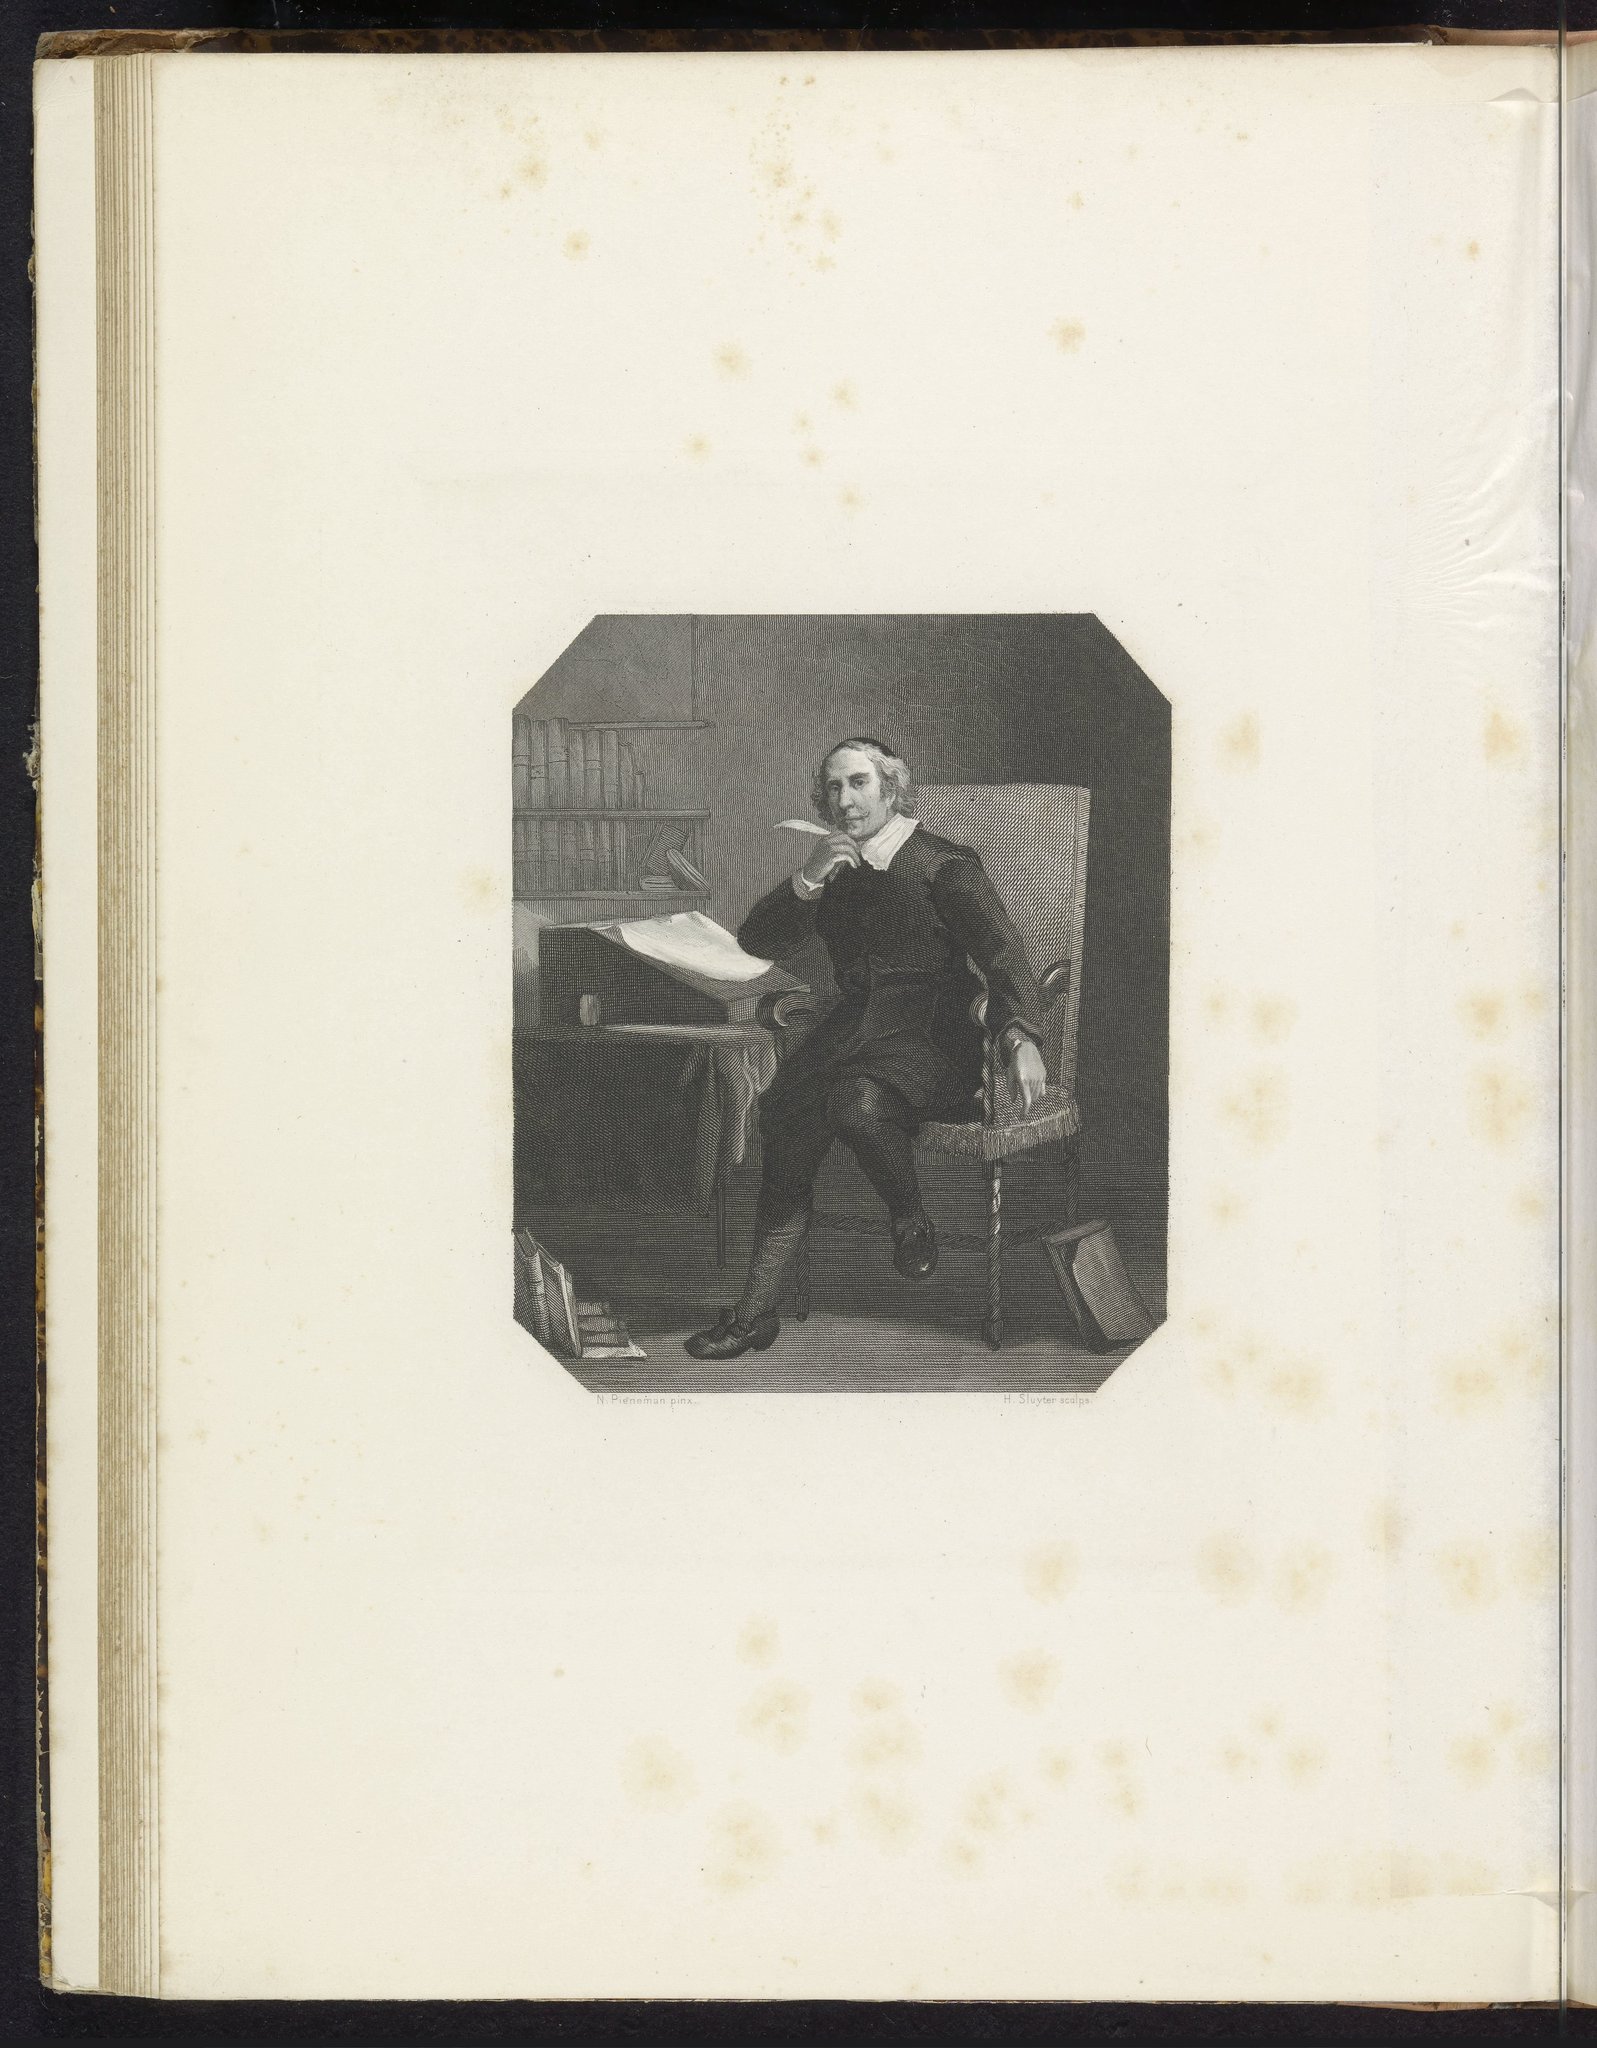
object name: history print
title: Joost van den Vondel, ca. 1650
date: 1865-1870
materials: paper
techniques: engraving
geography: netherlands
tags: cologne, amsterdam, joost van den vondel, author, poet writing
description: De dichter Joost van den Vondel, Gysbert Japicx, dichtend gezeten in een stoel, ca. 1650. Onderdeel van de groep staalgravures naar de schilderijen van de Historische Galerij der Maatschappij Arti et Amicitiae.